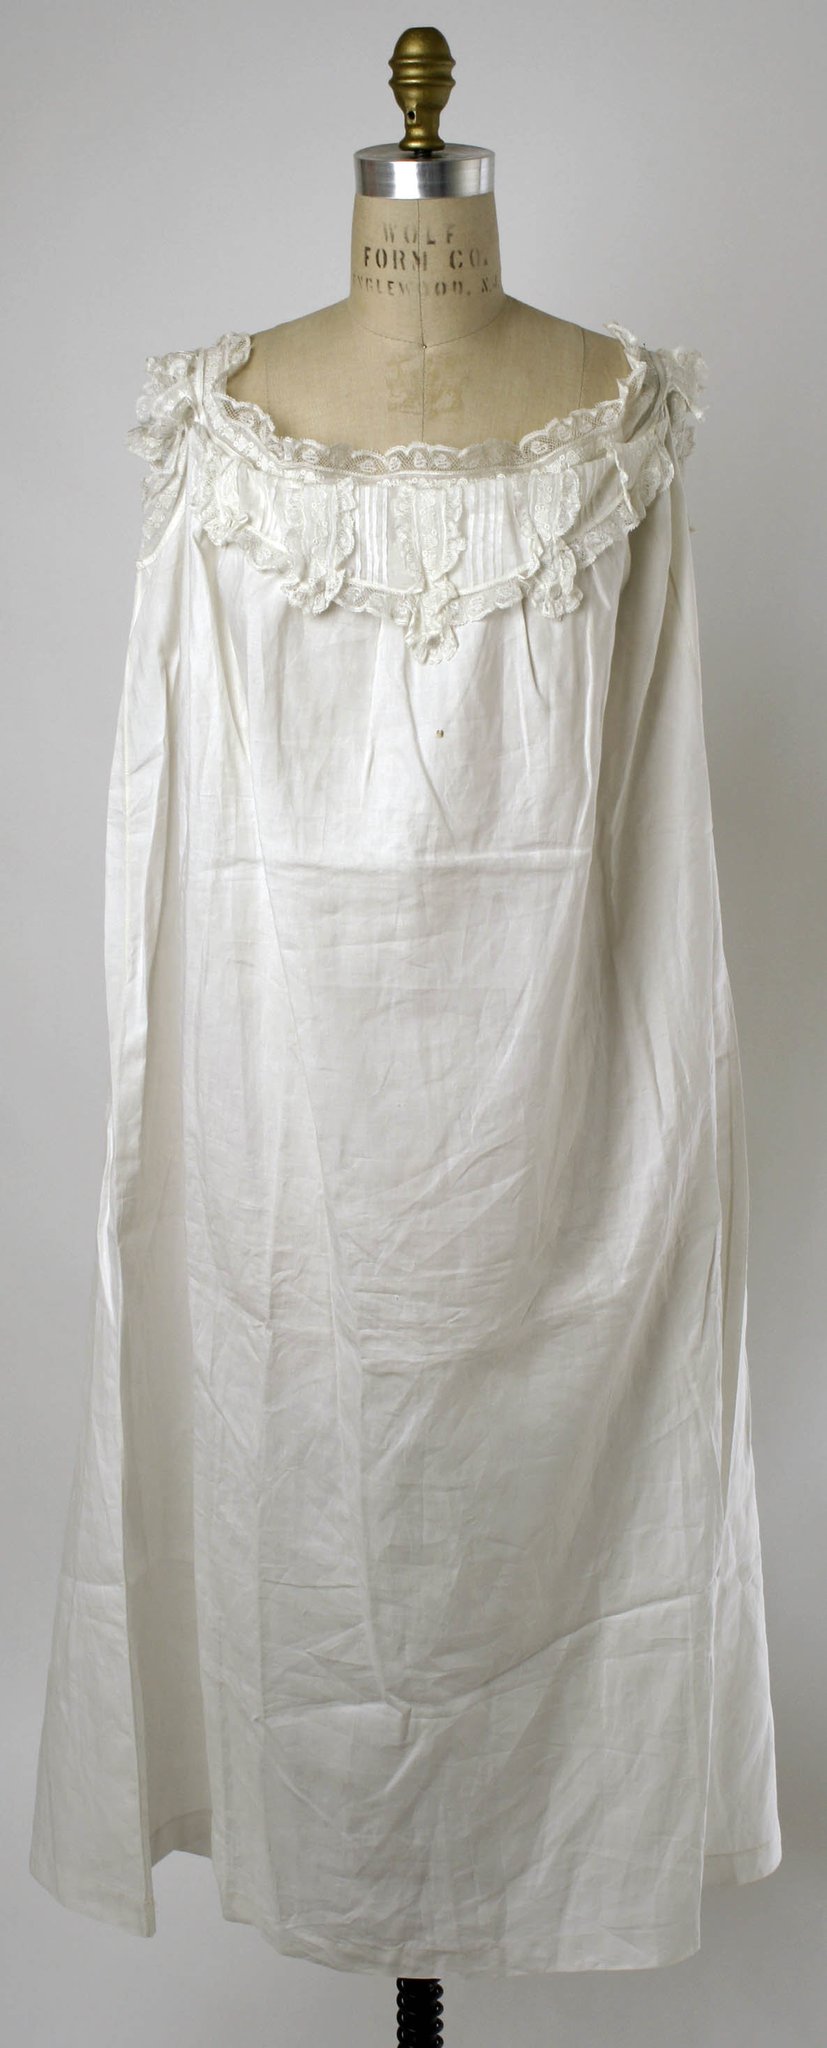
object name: chemise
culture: american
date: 1874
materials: cotton